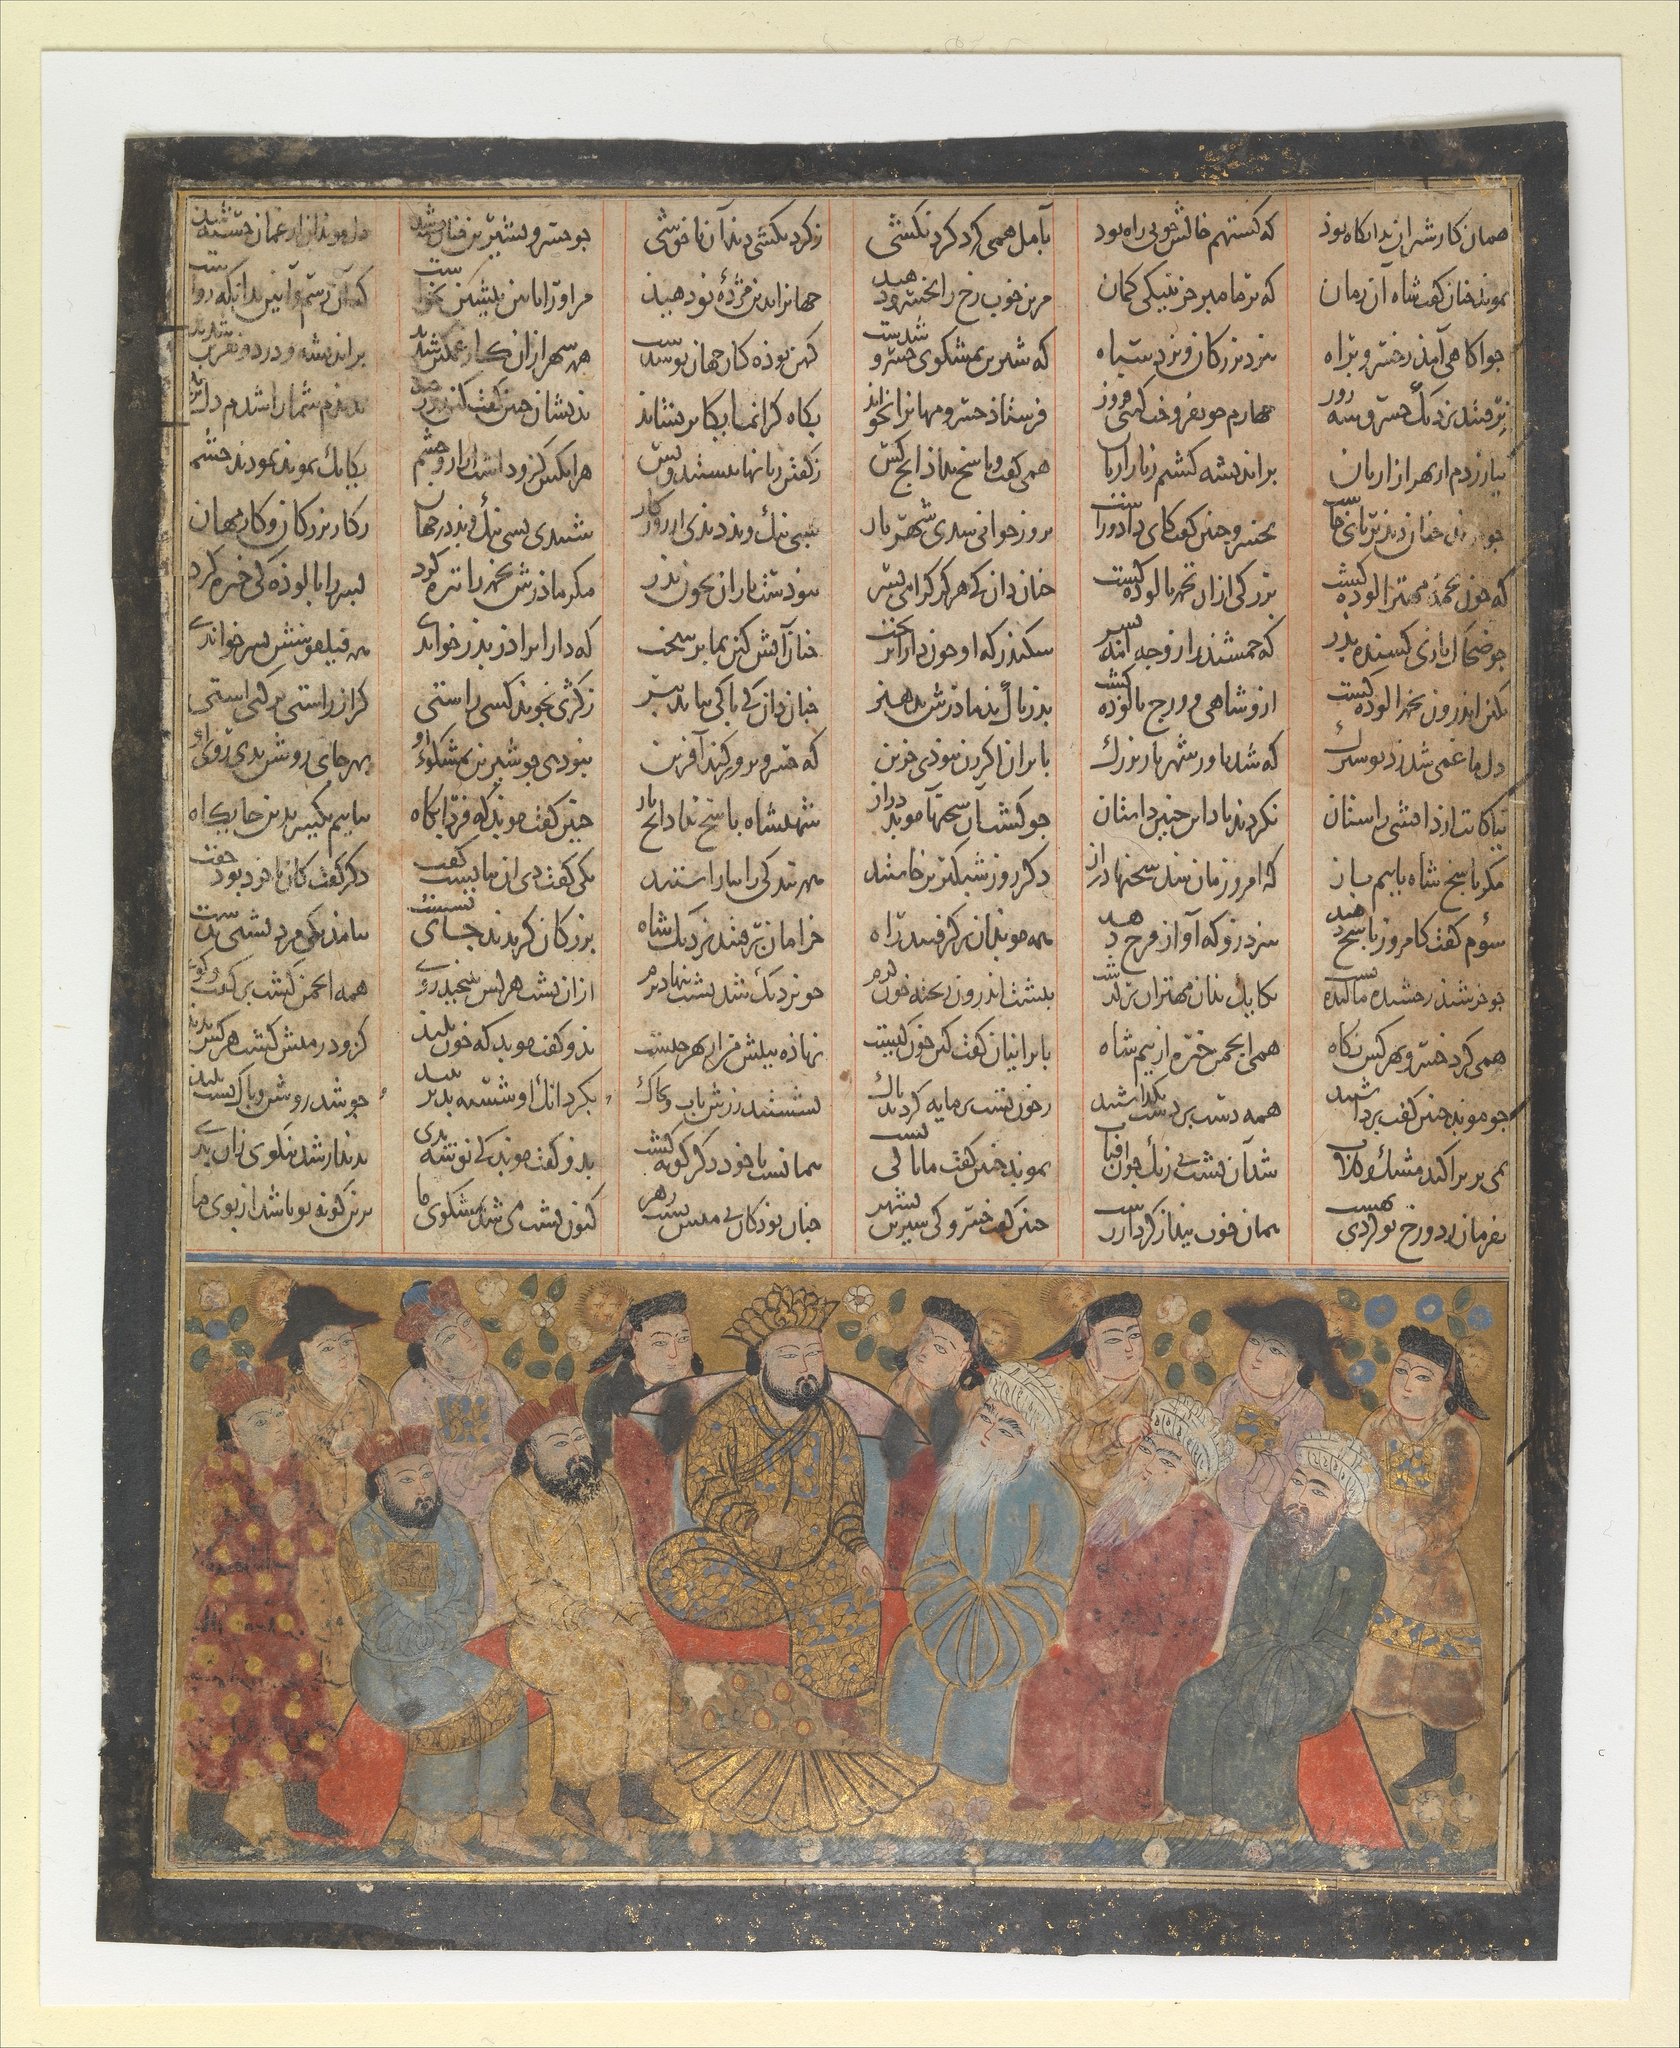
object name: folio from an illustrated manuscript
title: "The Nobles and Mubids Advise Khusrau Parviz about Shirin", Folio from the First Small Shahnama (Book of Kings)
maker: abu'l qasim firdausi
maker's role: author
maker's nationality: iranian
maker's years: 935-1020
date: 1300-1330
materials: gold, ink, paper, watercolor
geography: iran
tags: men,women